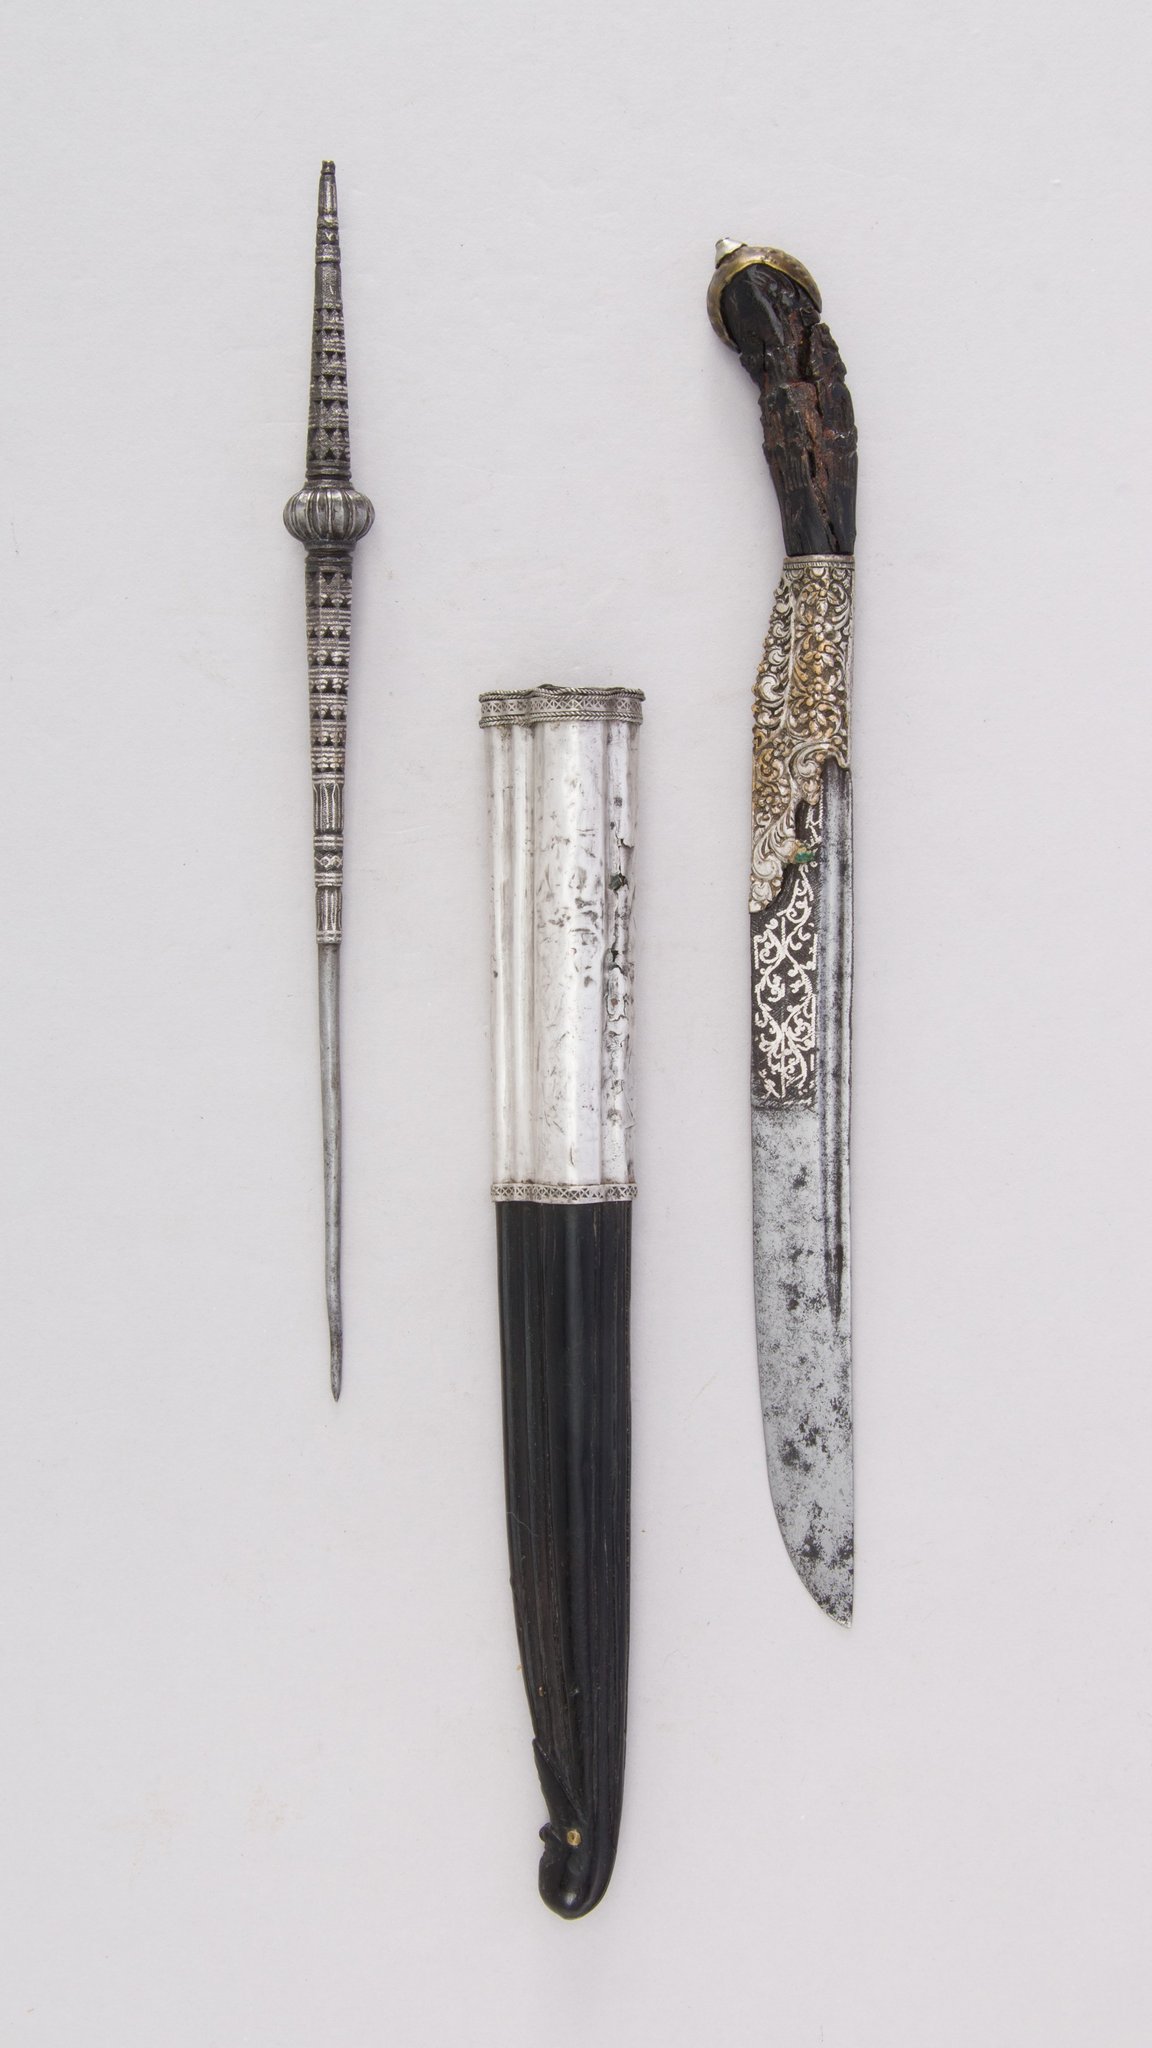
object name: knife piha kaetta with sheath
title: Knife (Piha Kaetta) with Stylus and Sheath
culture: sri lankan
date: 1701-1900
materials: brass, steel, wood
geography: sri lanka